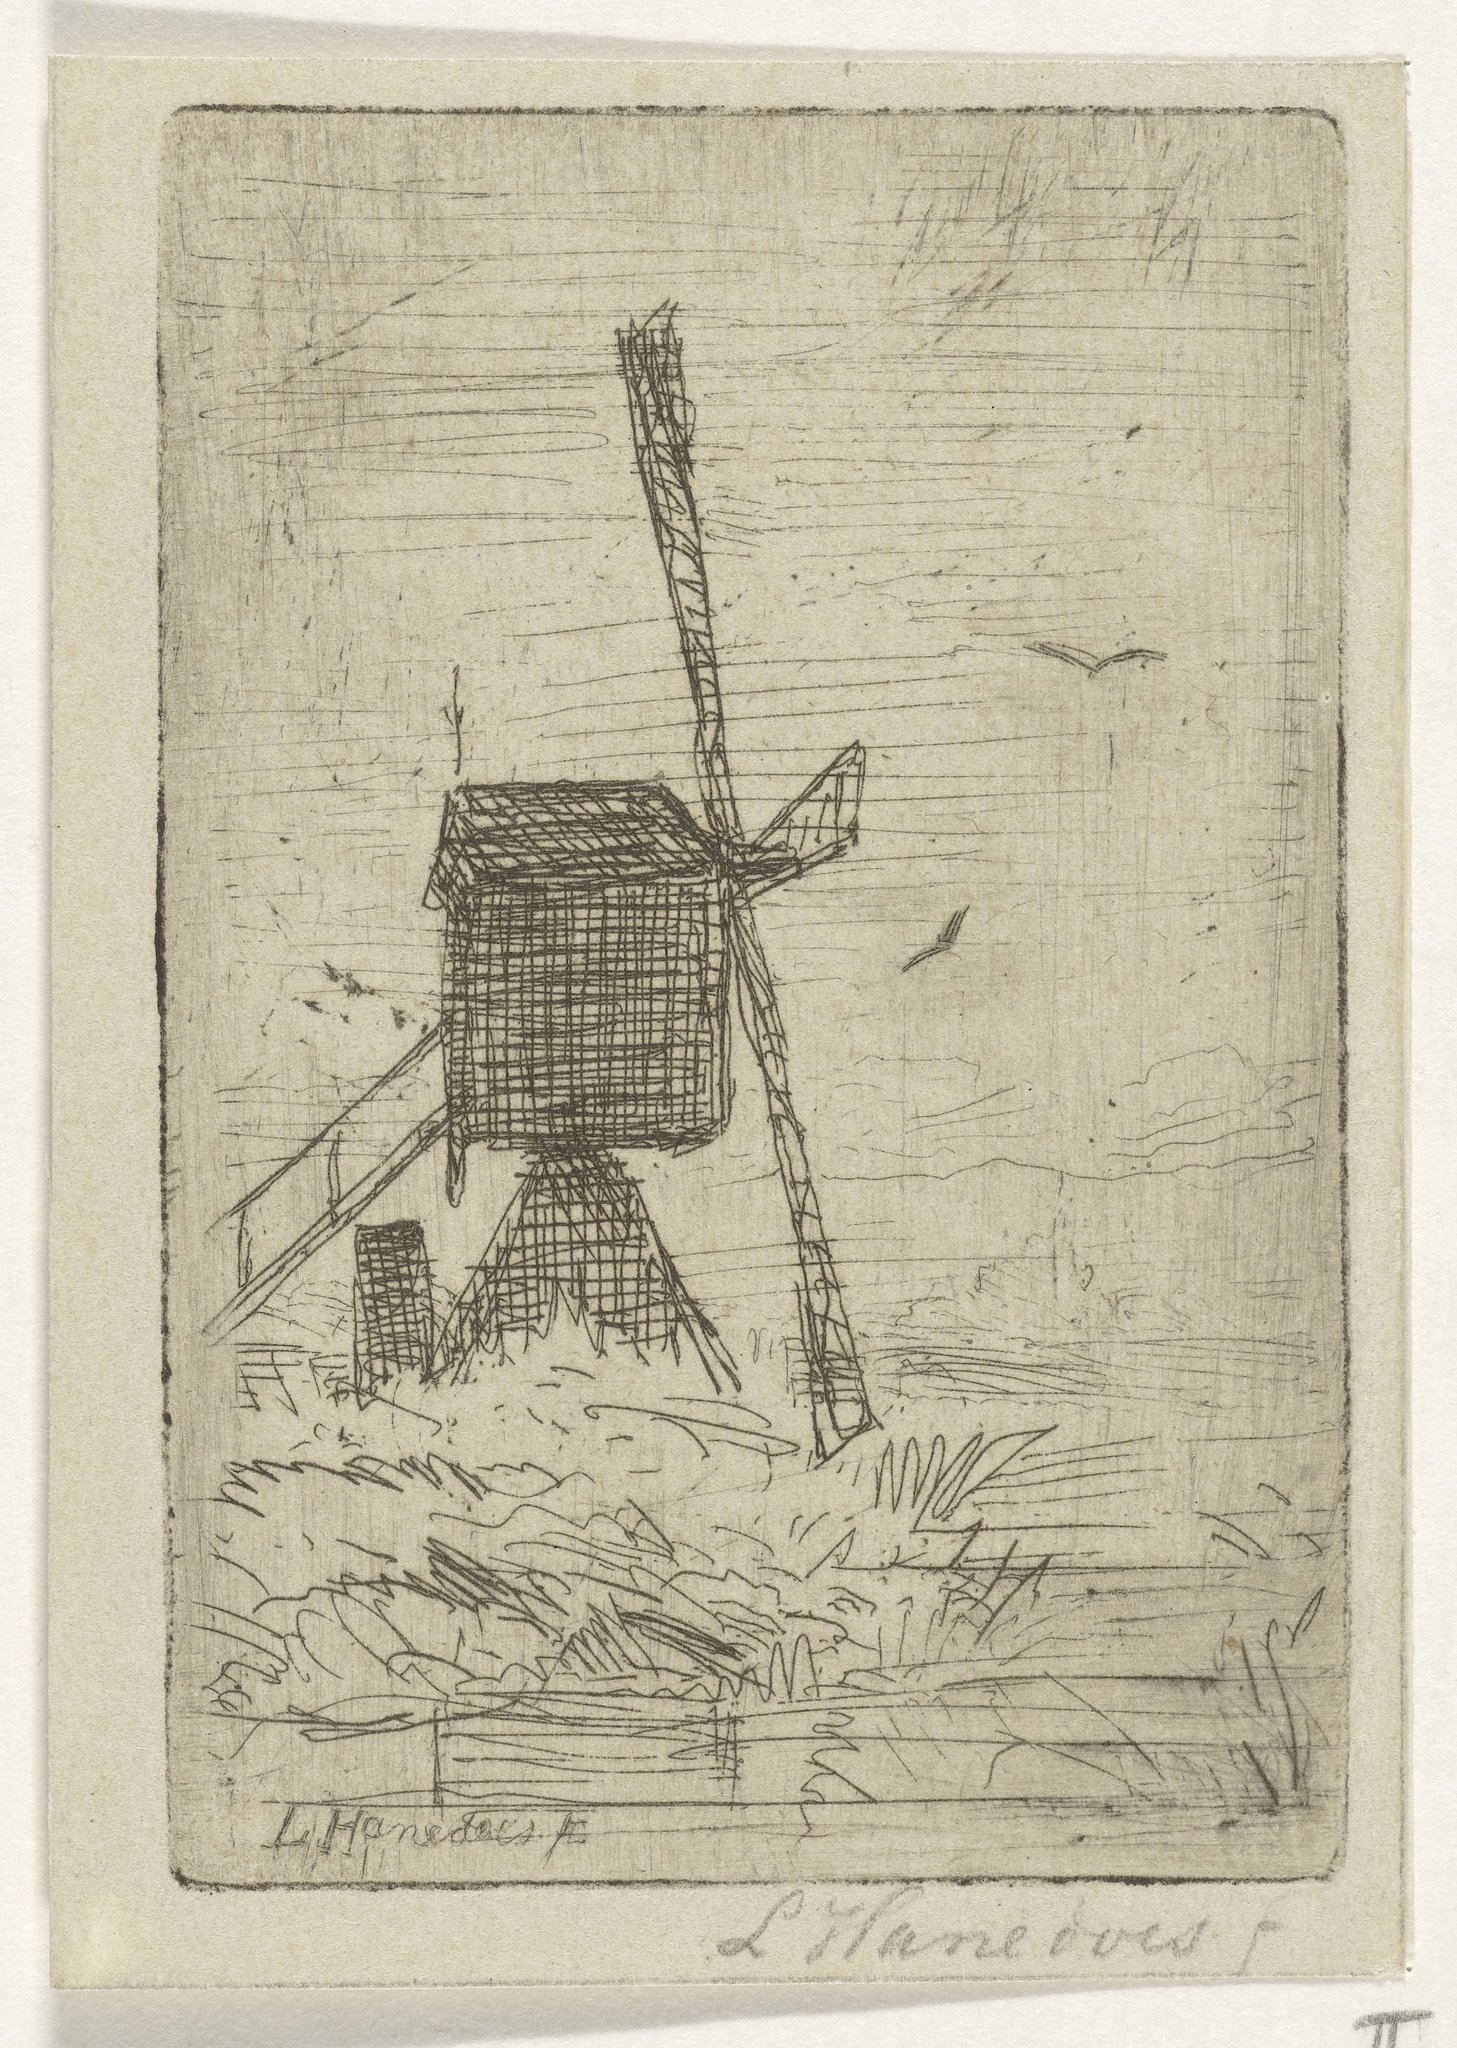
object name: print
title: Molen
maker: louwrens hanedoes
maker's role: painter, print maker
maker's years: 1822-1905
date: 1832-1882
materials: paper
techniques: etching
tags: windmill in landscape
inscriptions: collector's mark: Lugt 2227